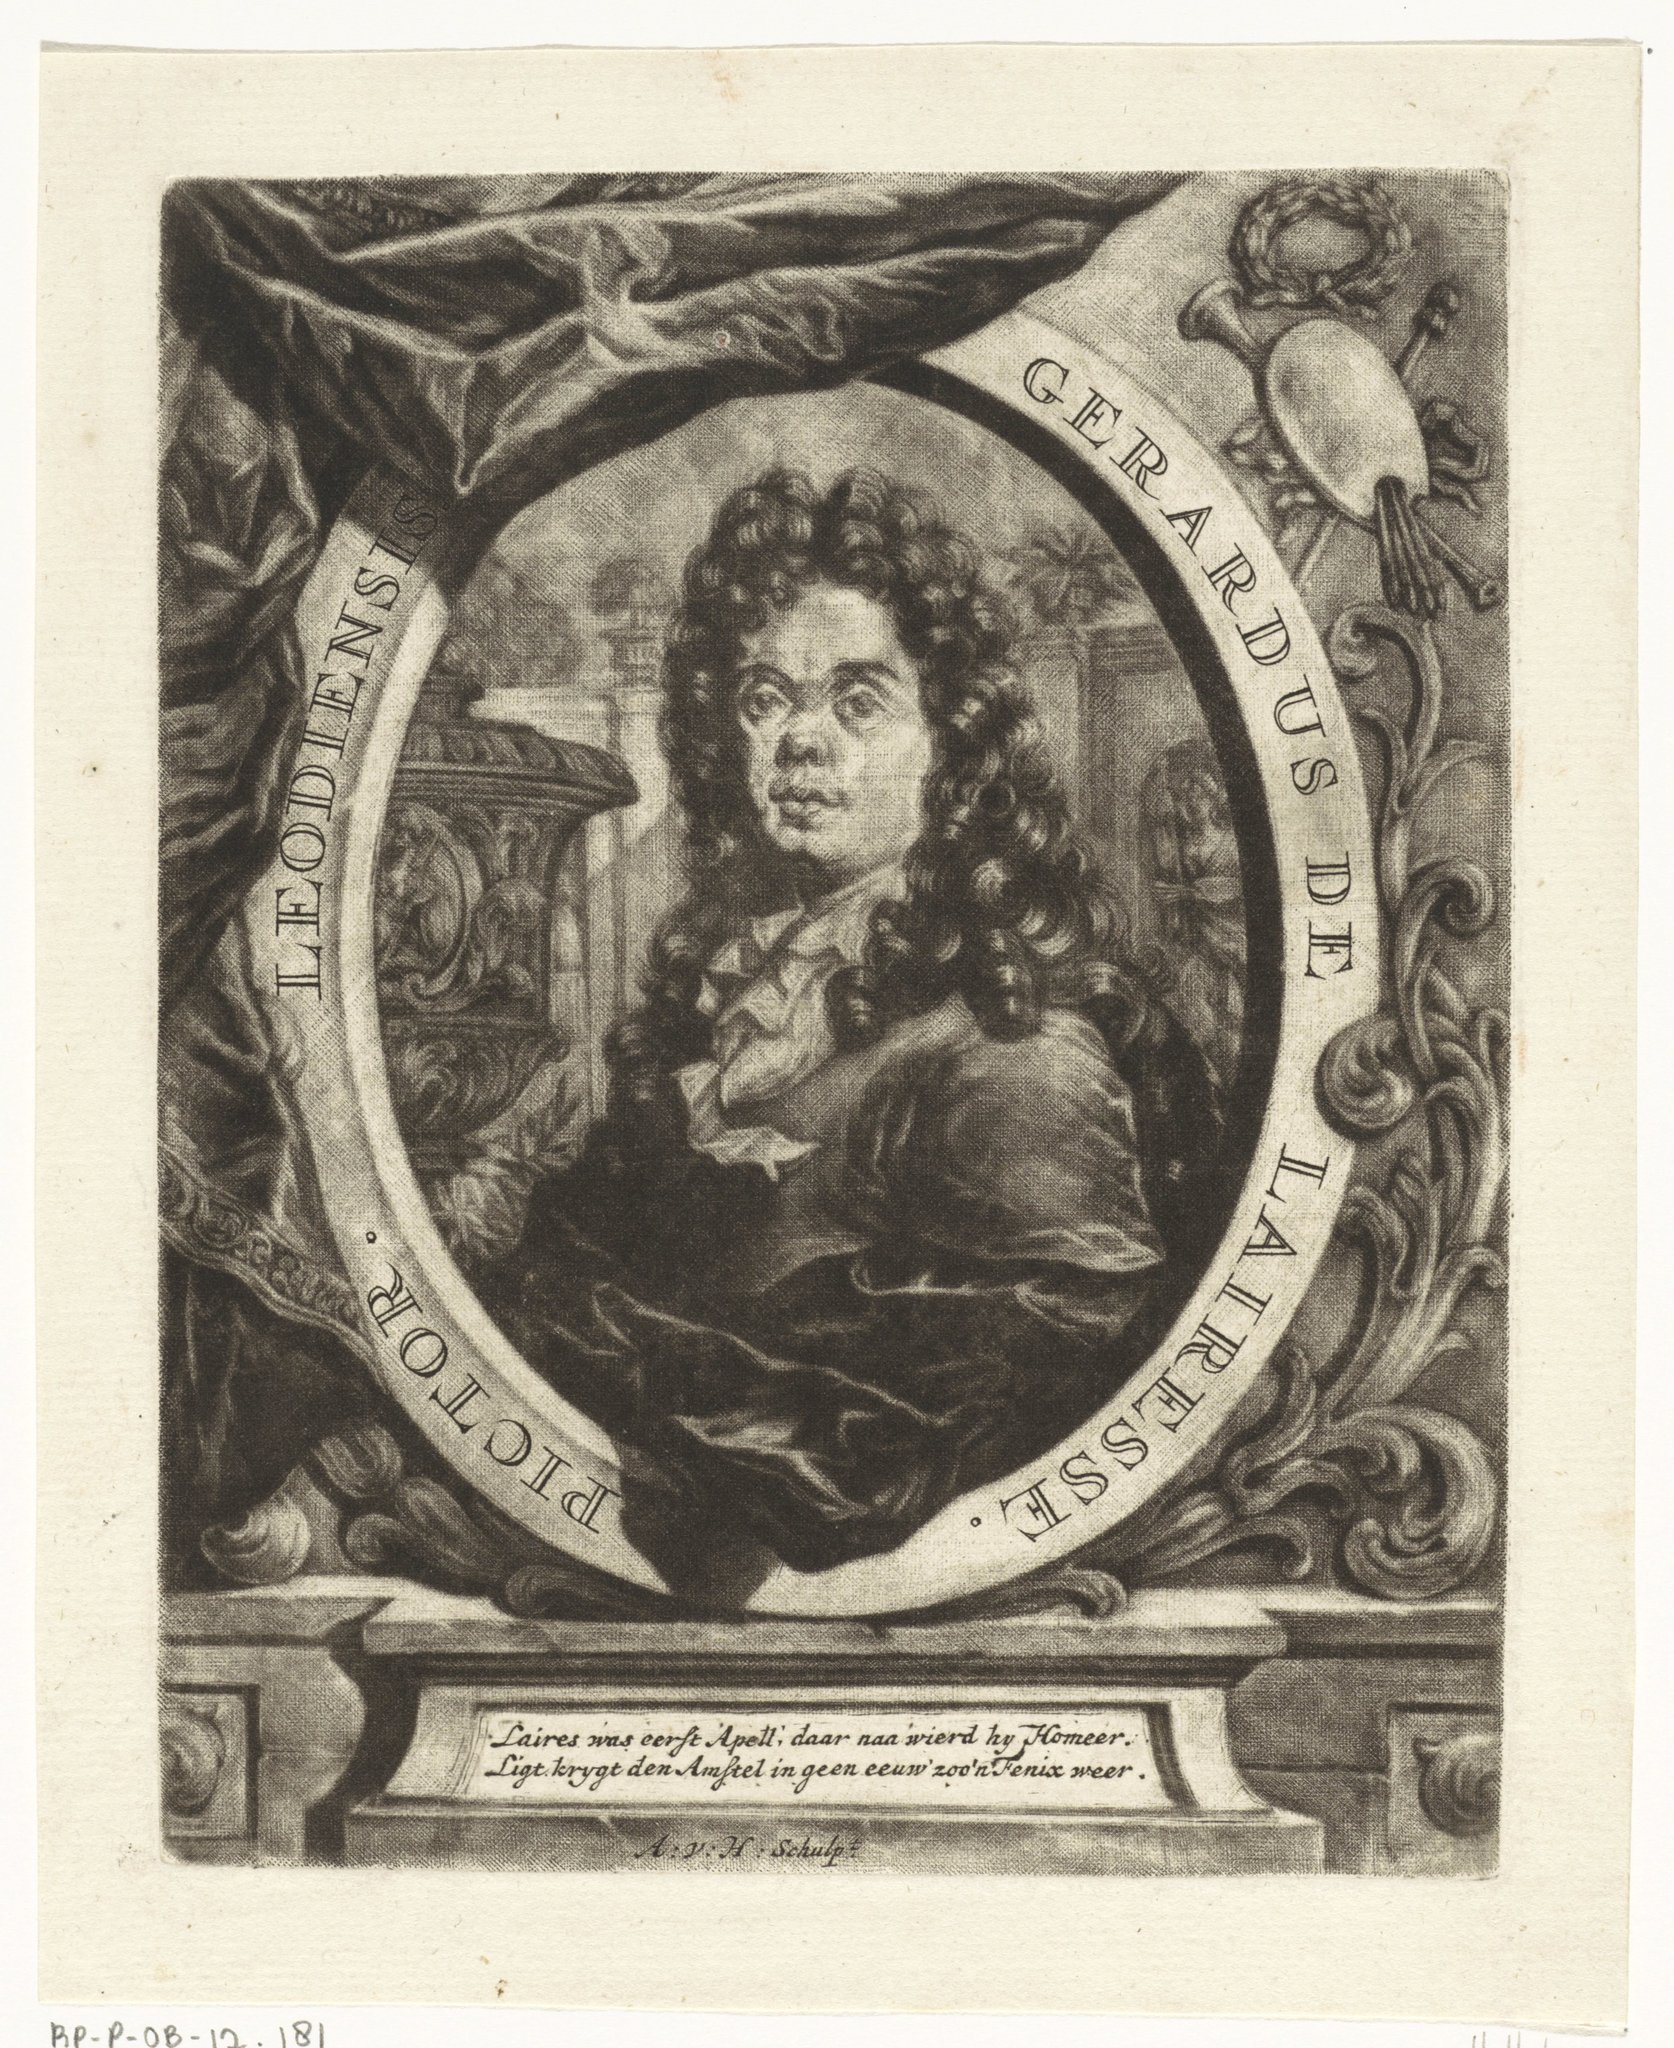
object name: print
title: Portret van Gerard de Lairesse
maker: arnoud van halen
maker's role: draughtsman, painter, print maker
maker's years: 1673-1732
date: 1683-1732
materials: paper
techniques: engraving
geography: amsterdam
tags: liège, amsterdam, painter, print maker, draughtsman, gerard de lairesse, garden, portrait, self-portrait of painter, tools, implements of painter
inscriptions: collector's mark: Lugt 240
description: De Luikse prentmaker en schilder Gerard de Lairesse in een tuin. Het portret is gevat in een rijk versierde omlijsting, met rechtsboven diverse schildersattributen.